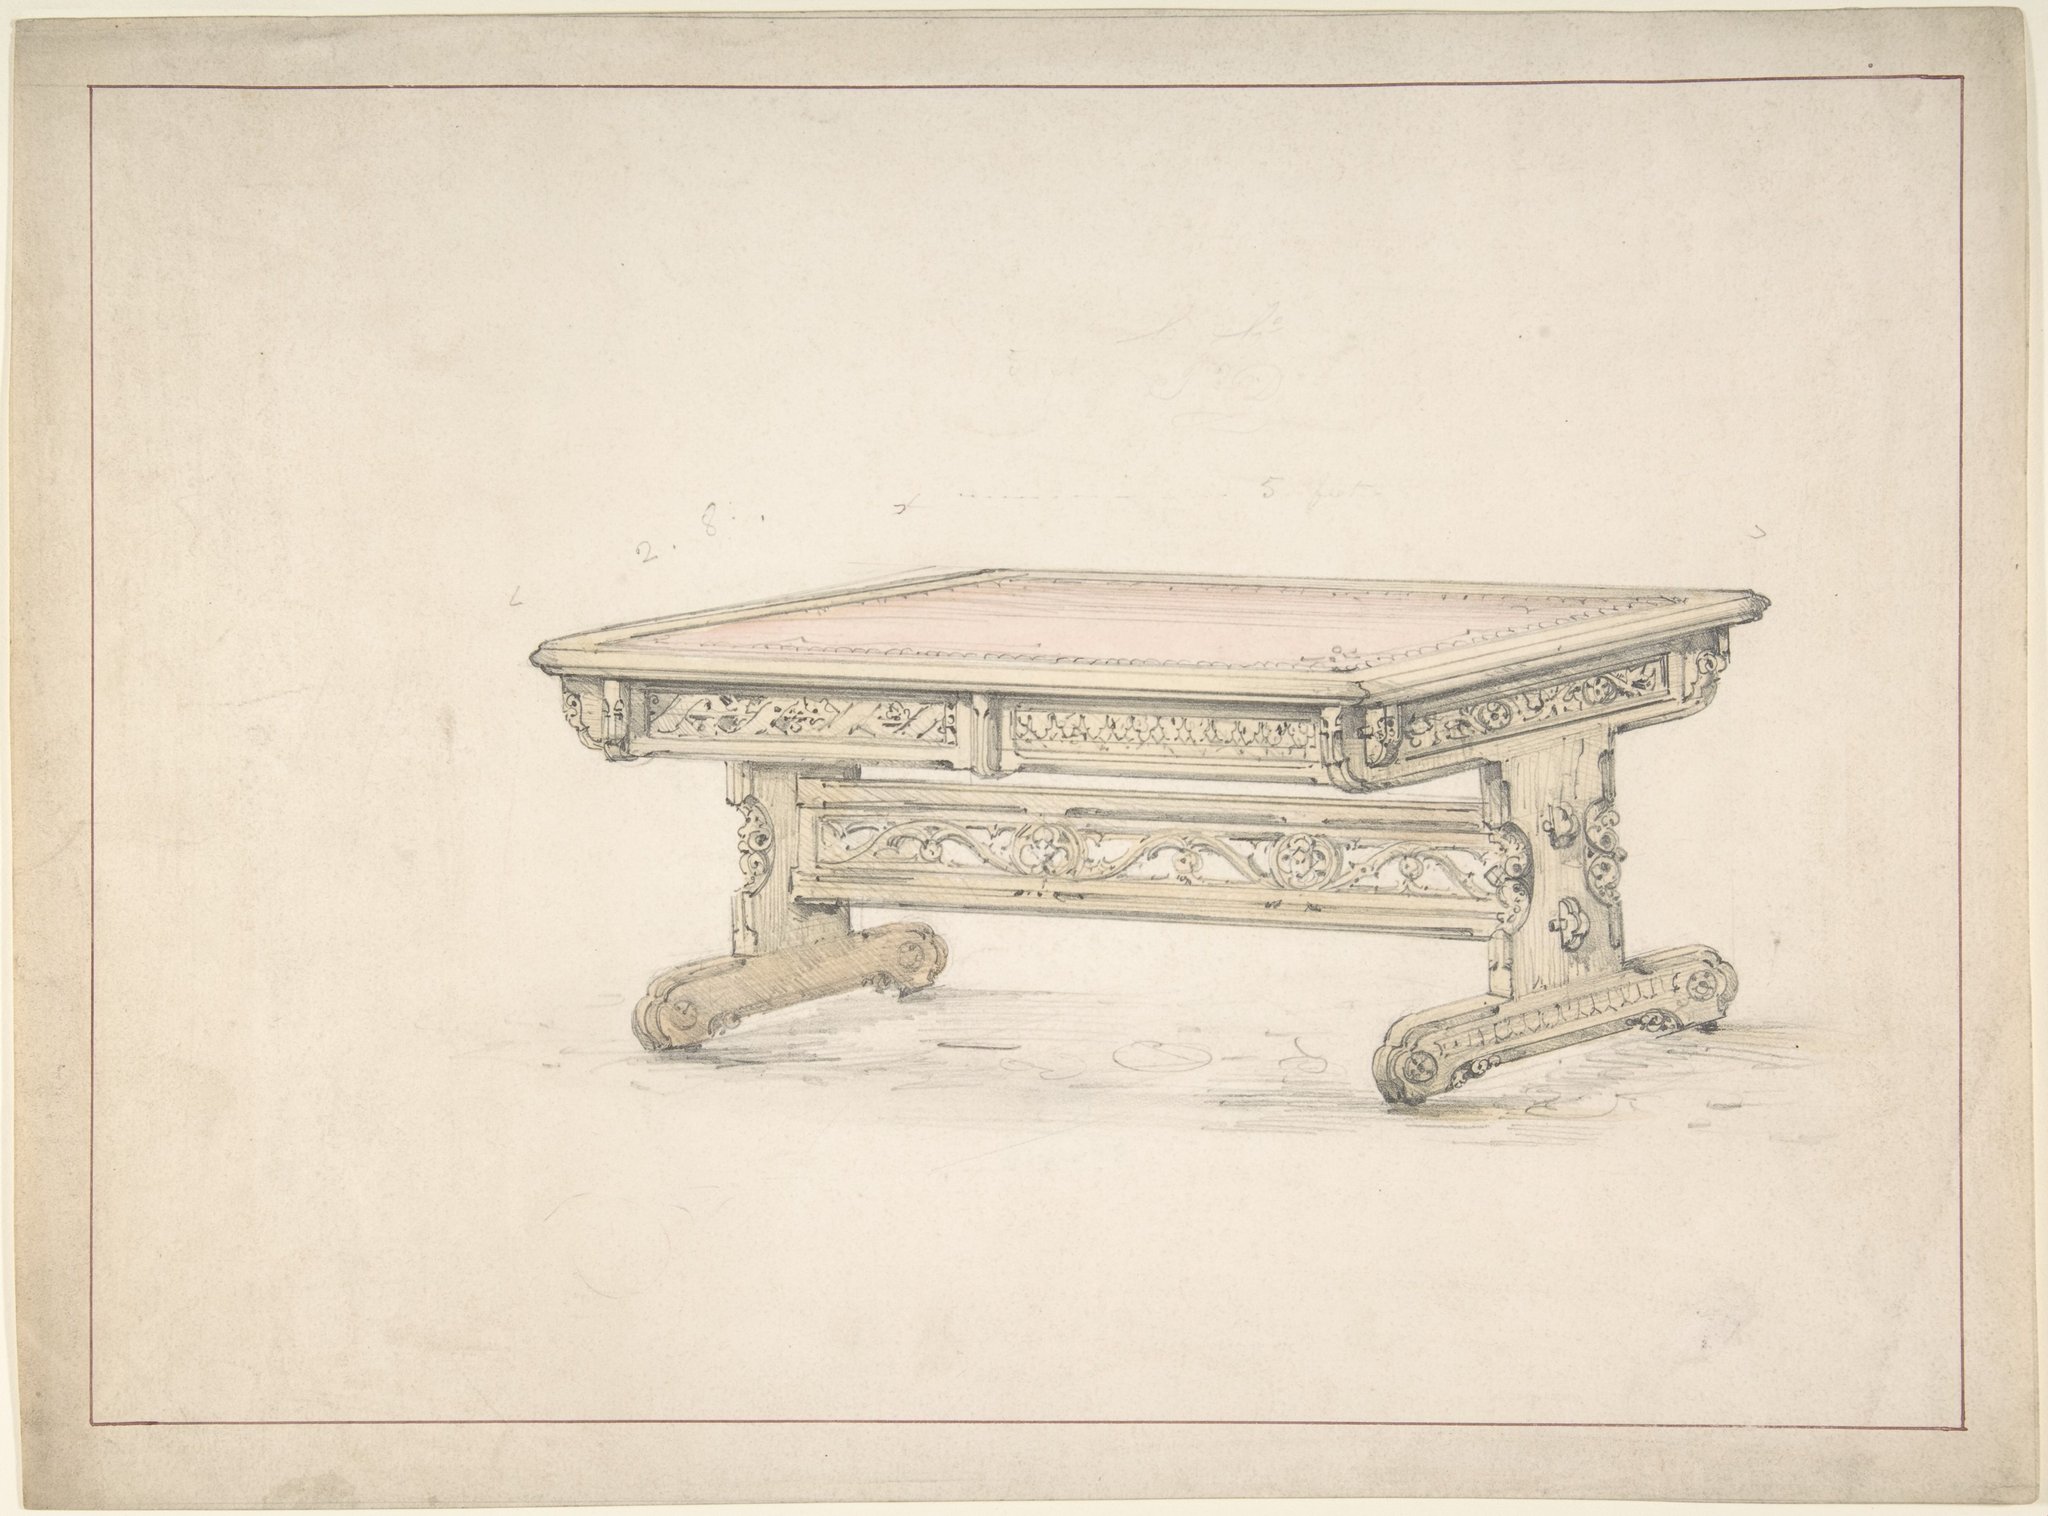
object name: drawing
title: Design for a Renaissance Style Table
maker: anonymous, british, 19th century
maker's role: artist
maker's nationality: british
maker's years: 1800-1900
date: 1801-1900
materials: graphite, watercolor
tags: tables